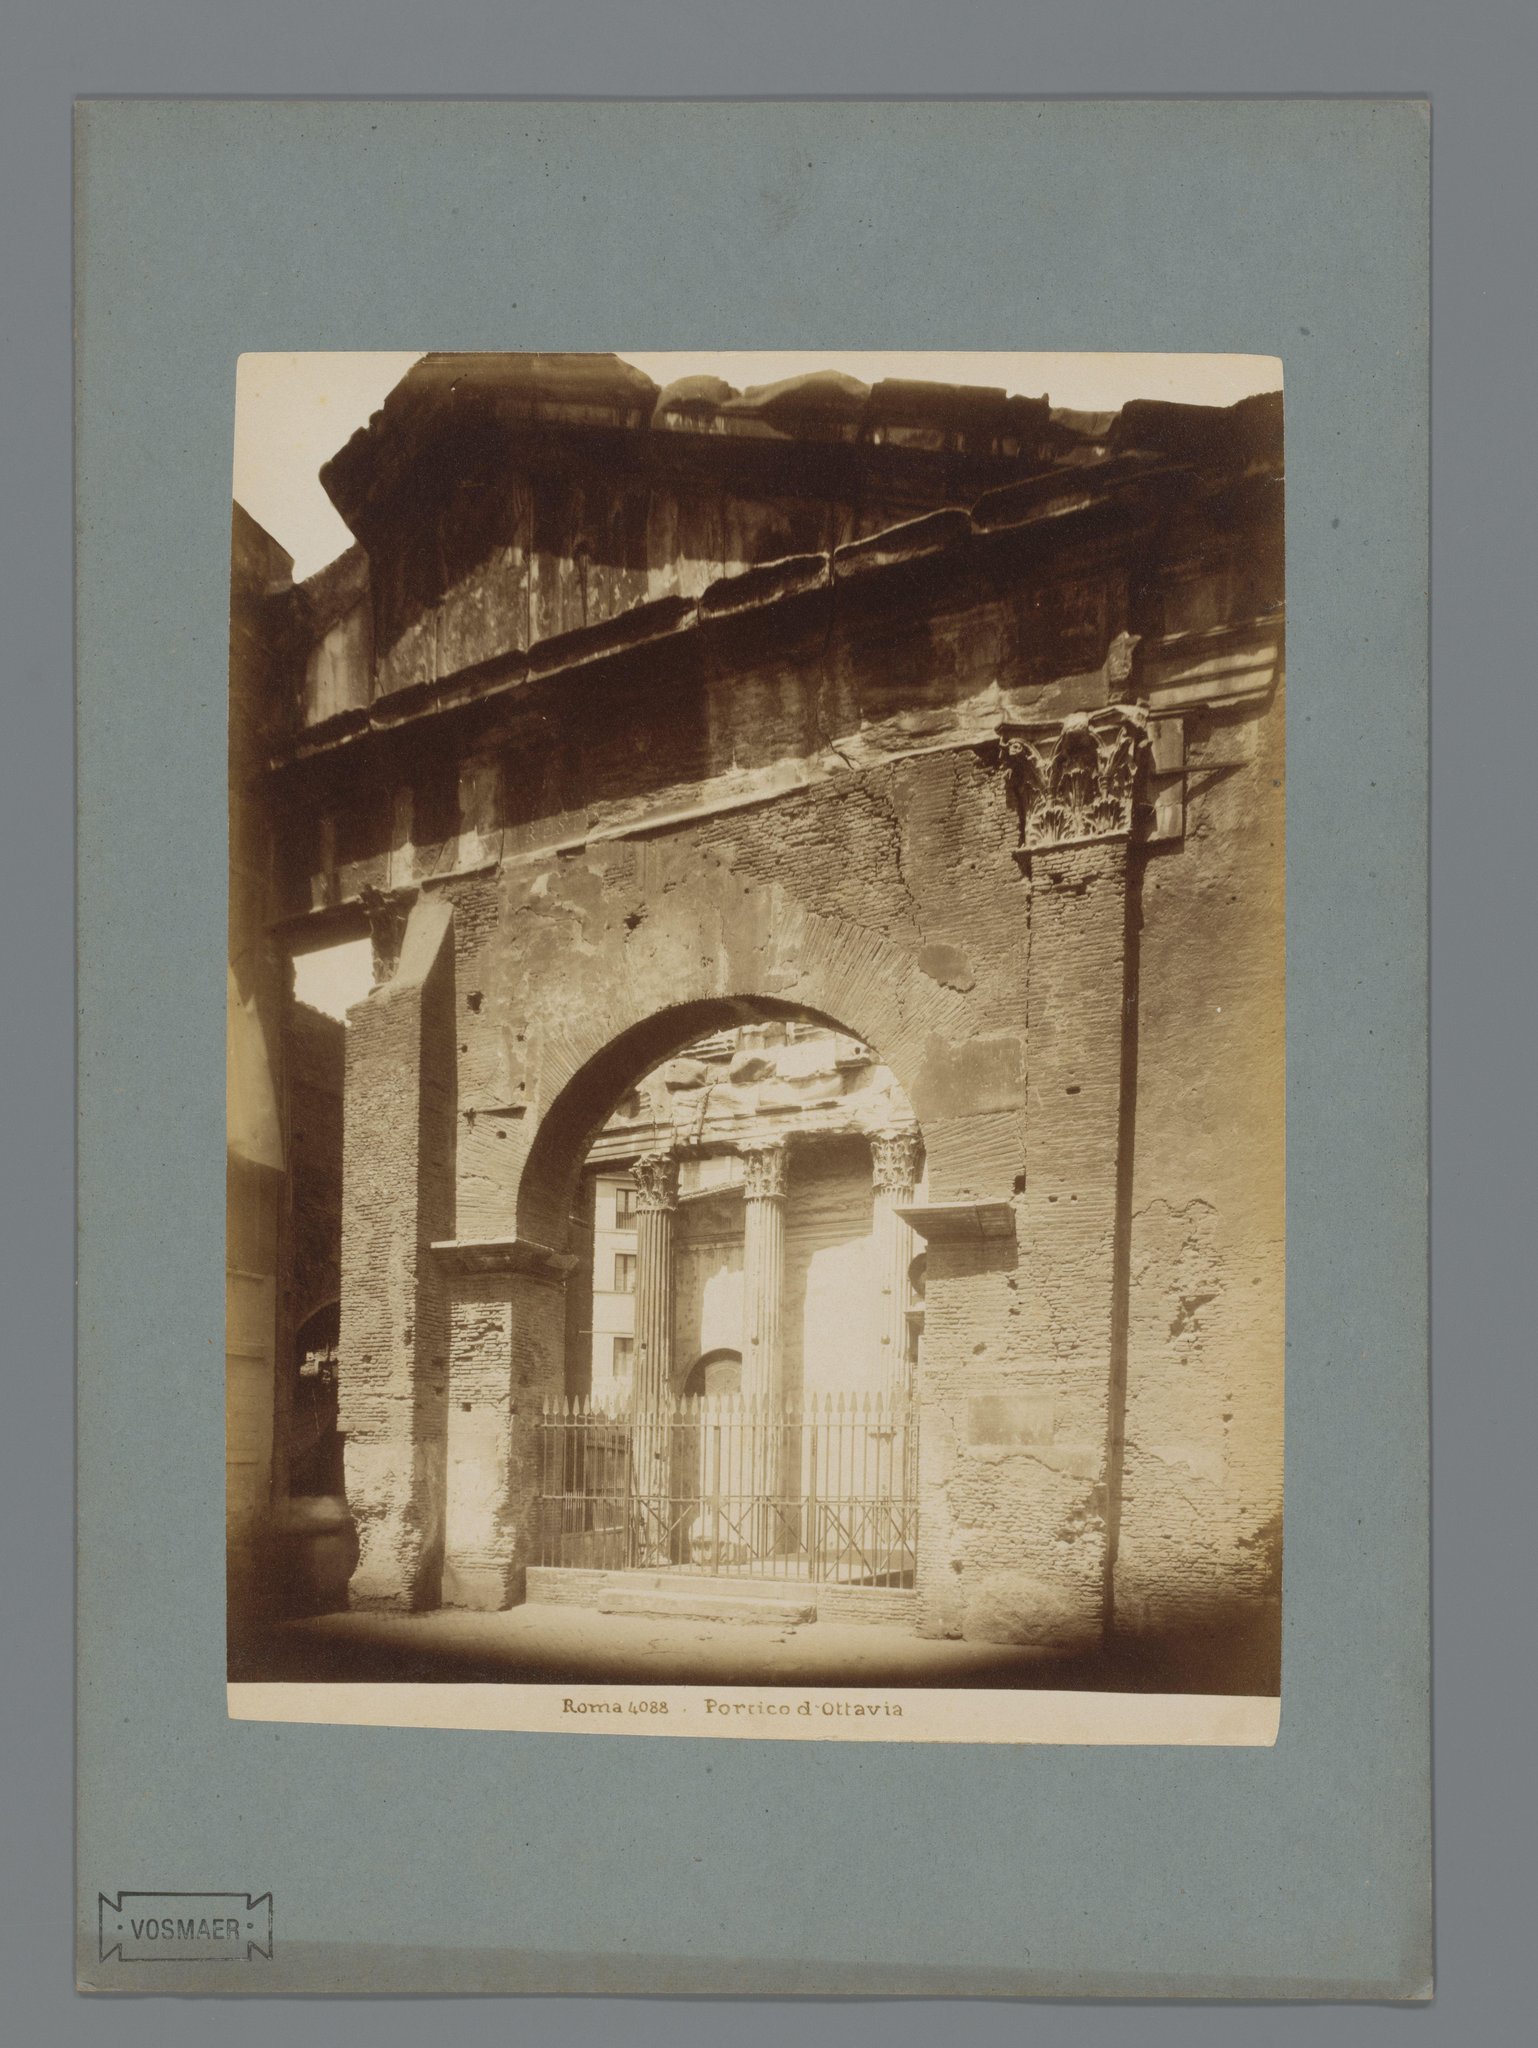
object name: photograph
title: Portico d'Ottavia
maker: Anonymous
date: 1851-1900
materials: cardboard, paper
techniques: albumen print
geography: rome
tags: ruin of a building ~ architecture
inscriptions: number: ‘4088.’, collector's mark: ‘VOSMAER’